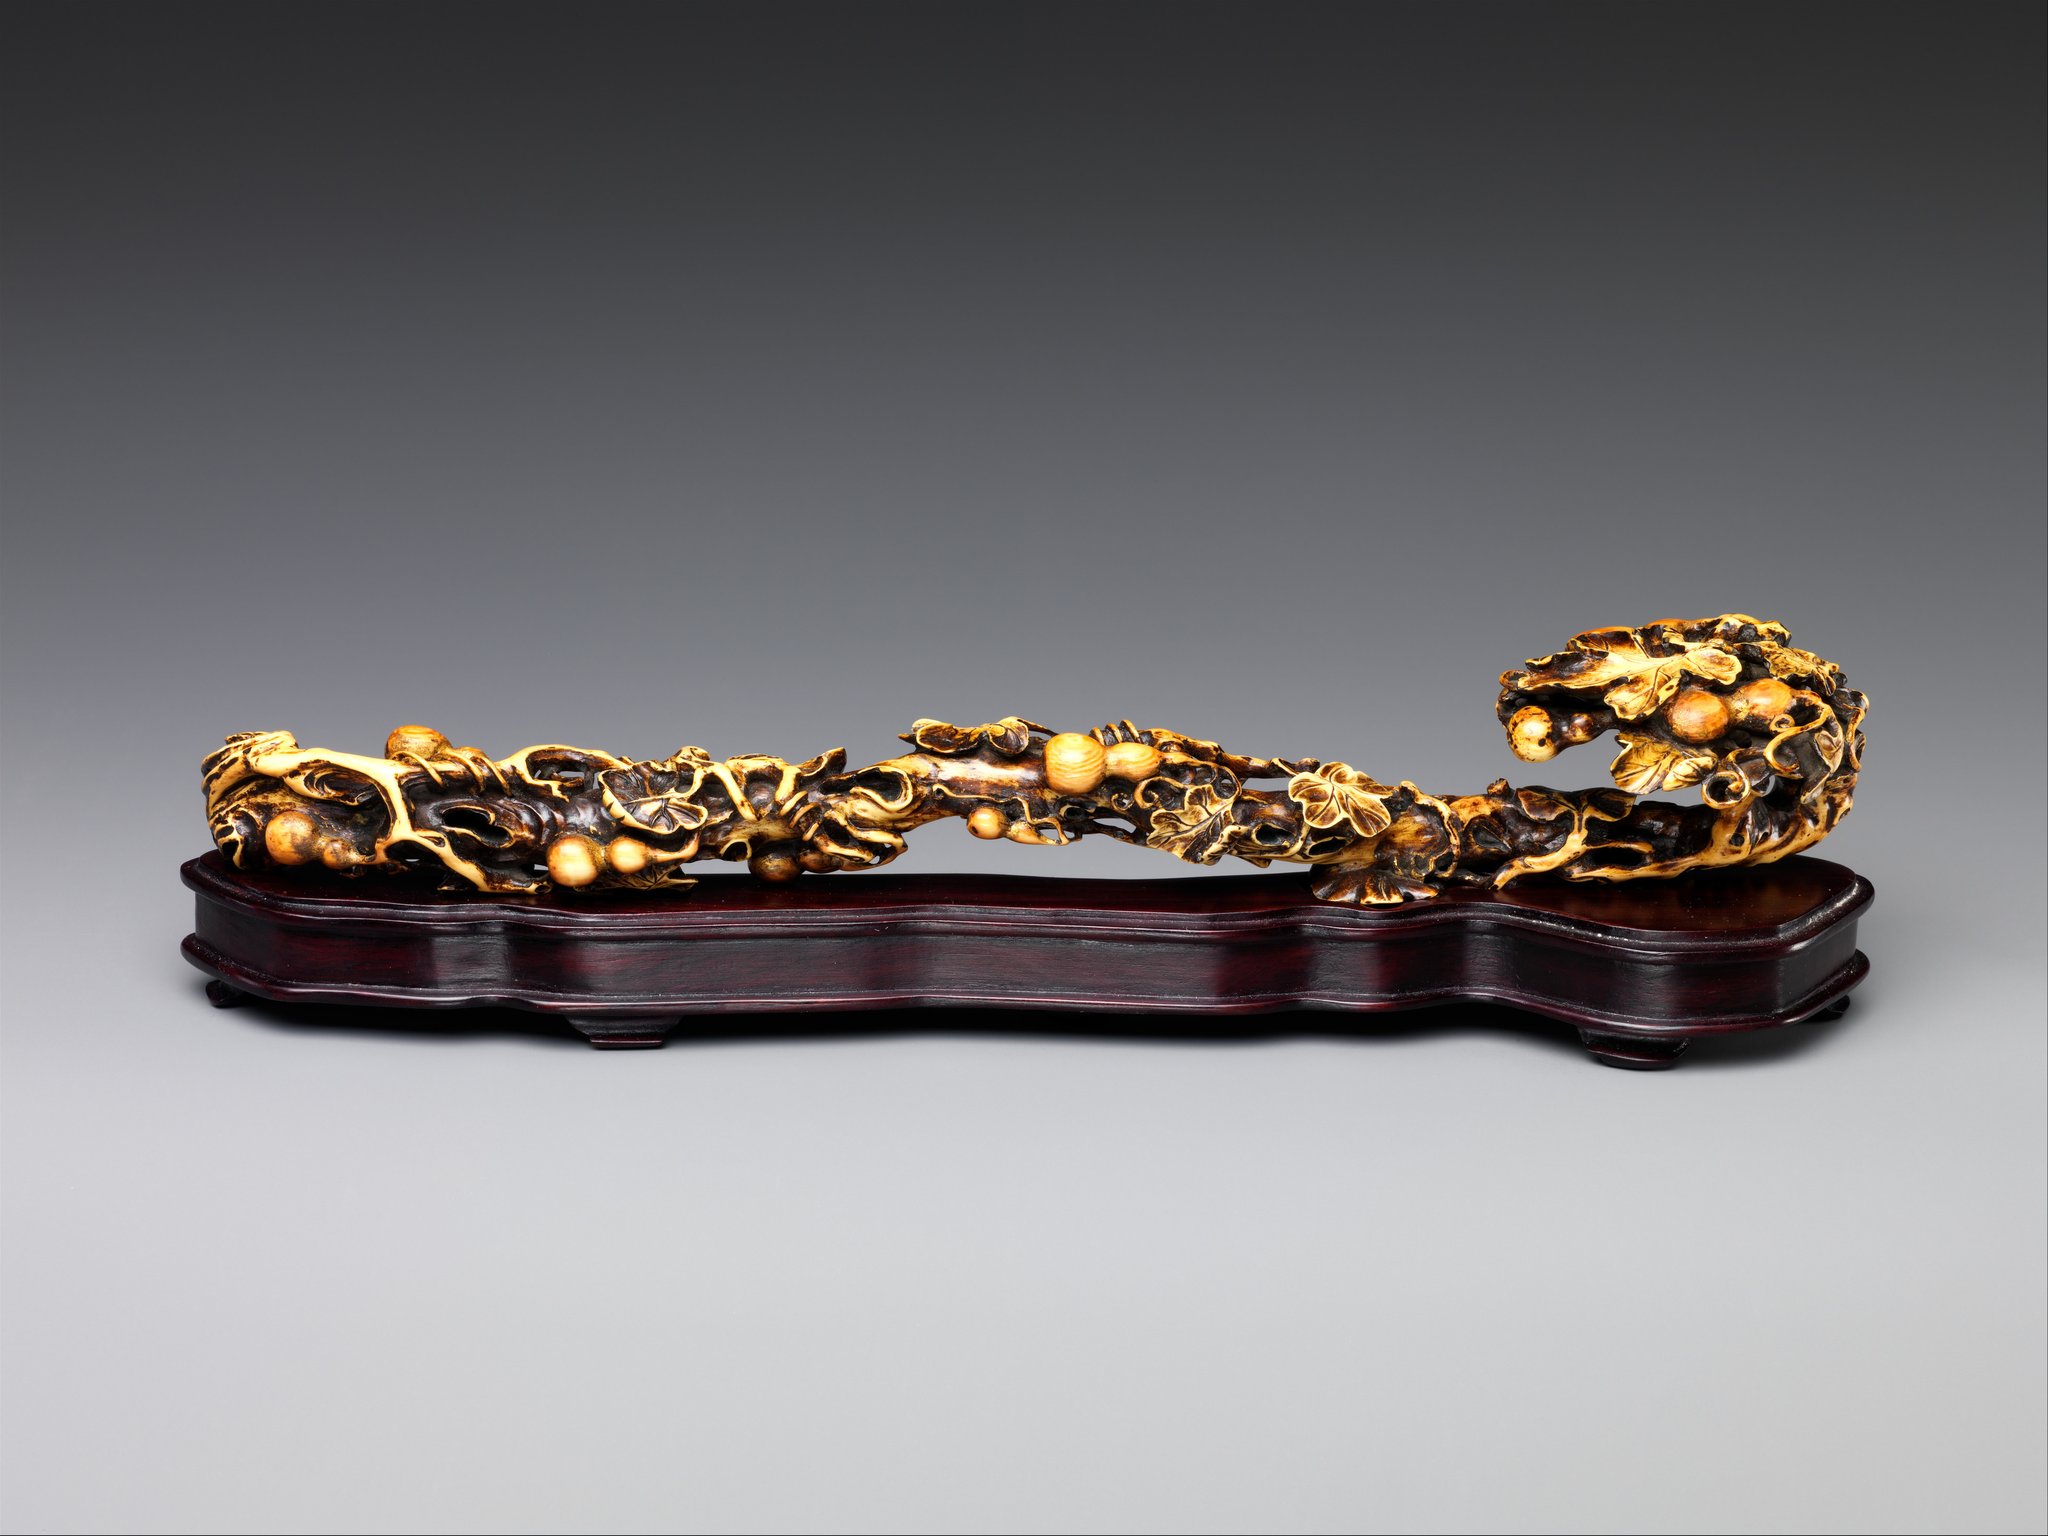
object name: scepter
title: Scepter (ruyi) with gourds and vines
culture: chinese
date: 1767-1833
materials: ivory, pigment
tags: vines